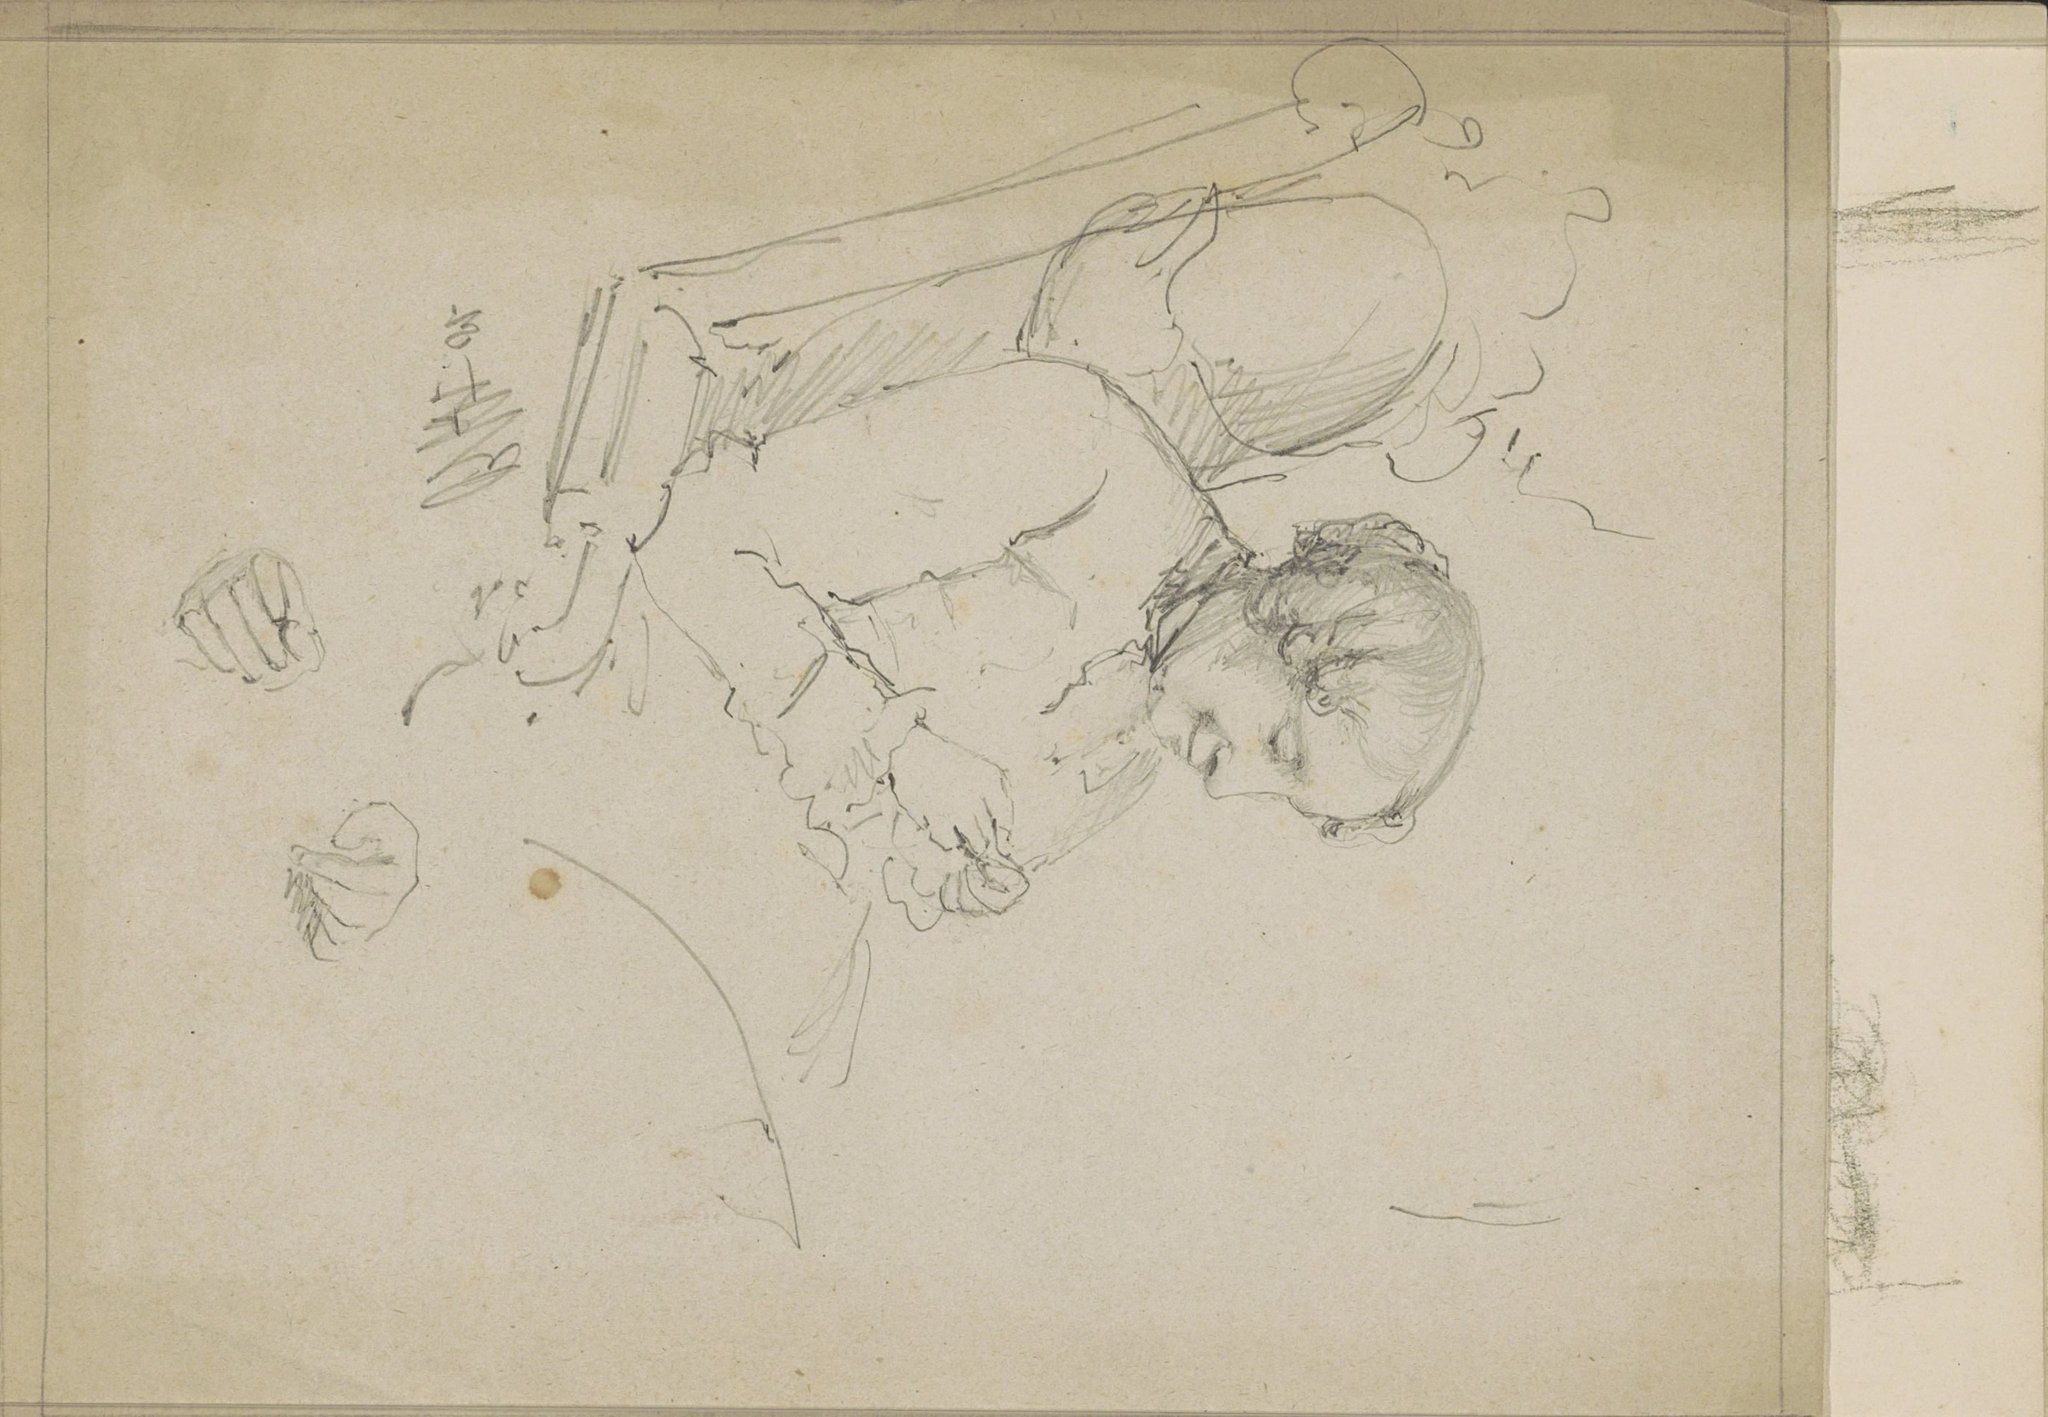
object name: sketchbook leaf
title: Handwerkende oudere vrouw in een stoel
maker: a.a.l. de grammont-hubrecht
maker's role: draughtsman, painter, print maker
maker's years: 1855-1913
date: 1865-1913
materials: paper, pencil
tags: sitting figure, adult woman, hand, home sewing; repair of clothes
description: Tevens studies van handen. Losse schets tussen pagina 1 en 2 uit een schetsboek met 68 bladen.